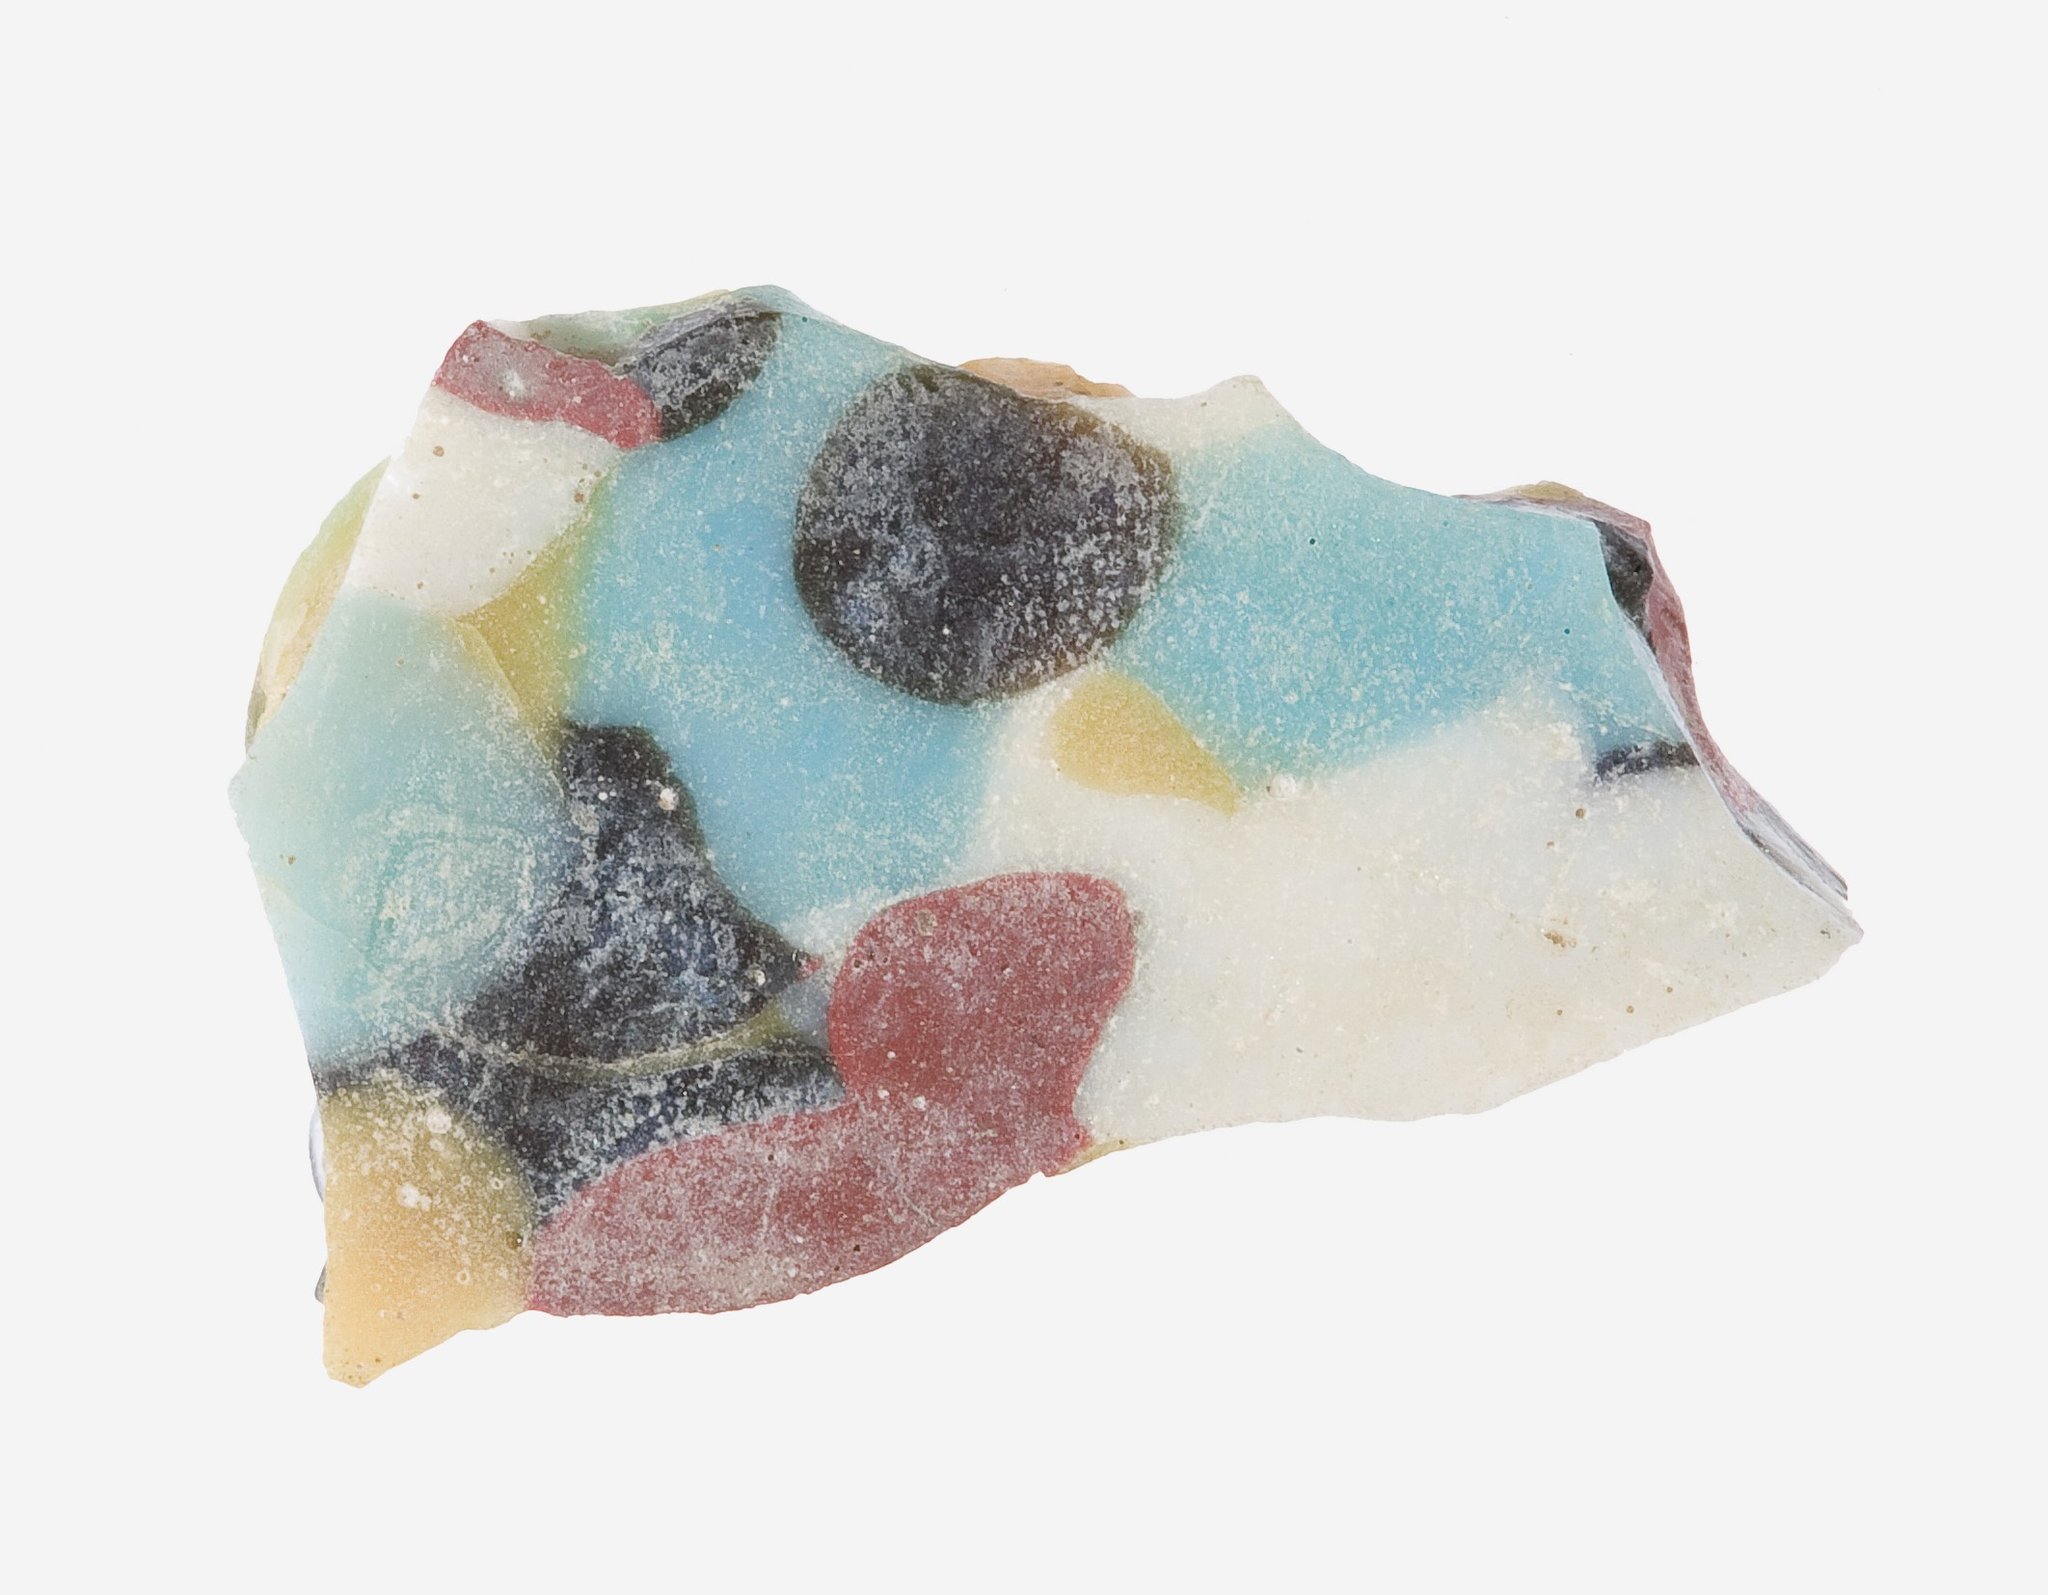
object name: vessel fragment, mosaic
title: Fragment of a Dish of Polychrome Mosaic Glass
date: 1390-1352 BCE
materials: glass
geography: egypt